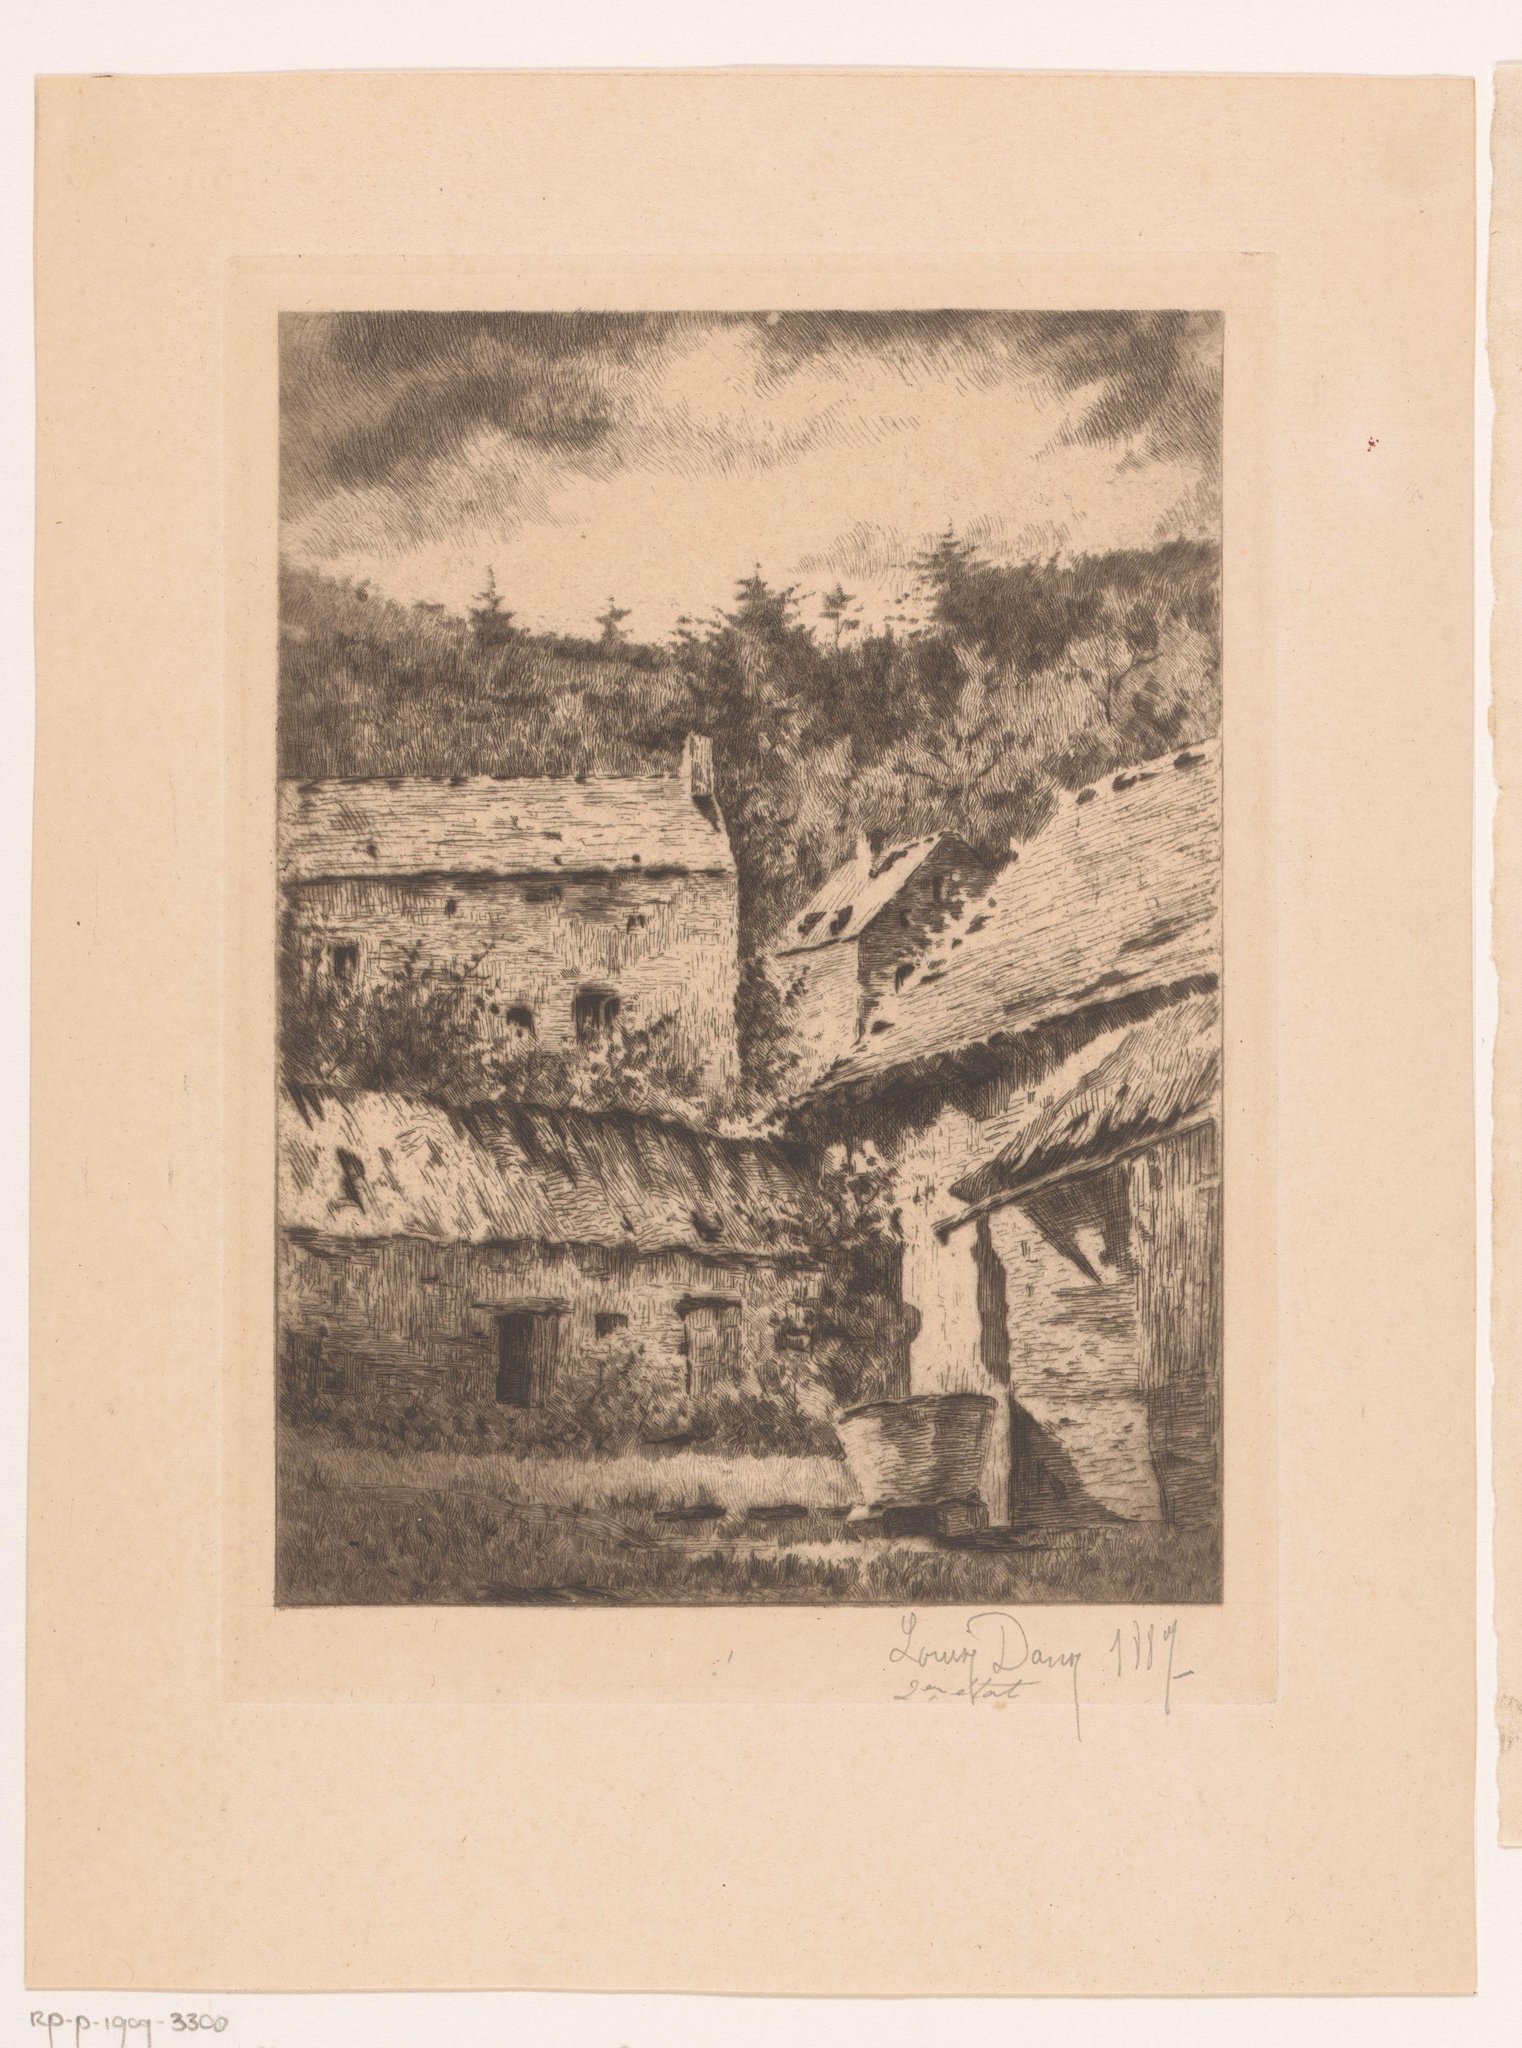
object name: print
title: Heuvelachtig landschap met boerenhofstede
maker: louise danse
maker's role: painter, print maker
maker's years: 1867-1948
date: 1887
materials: paper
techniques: drypoint, etching, intaglio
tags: farm or solitary house in landscape, farm (building)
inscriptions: annotation: ‘2me état’, collector's mark: Lugt 2228